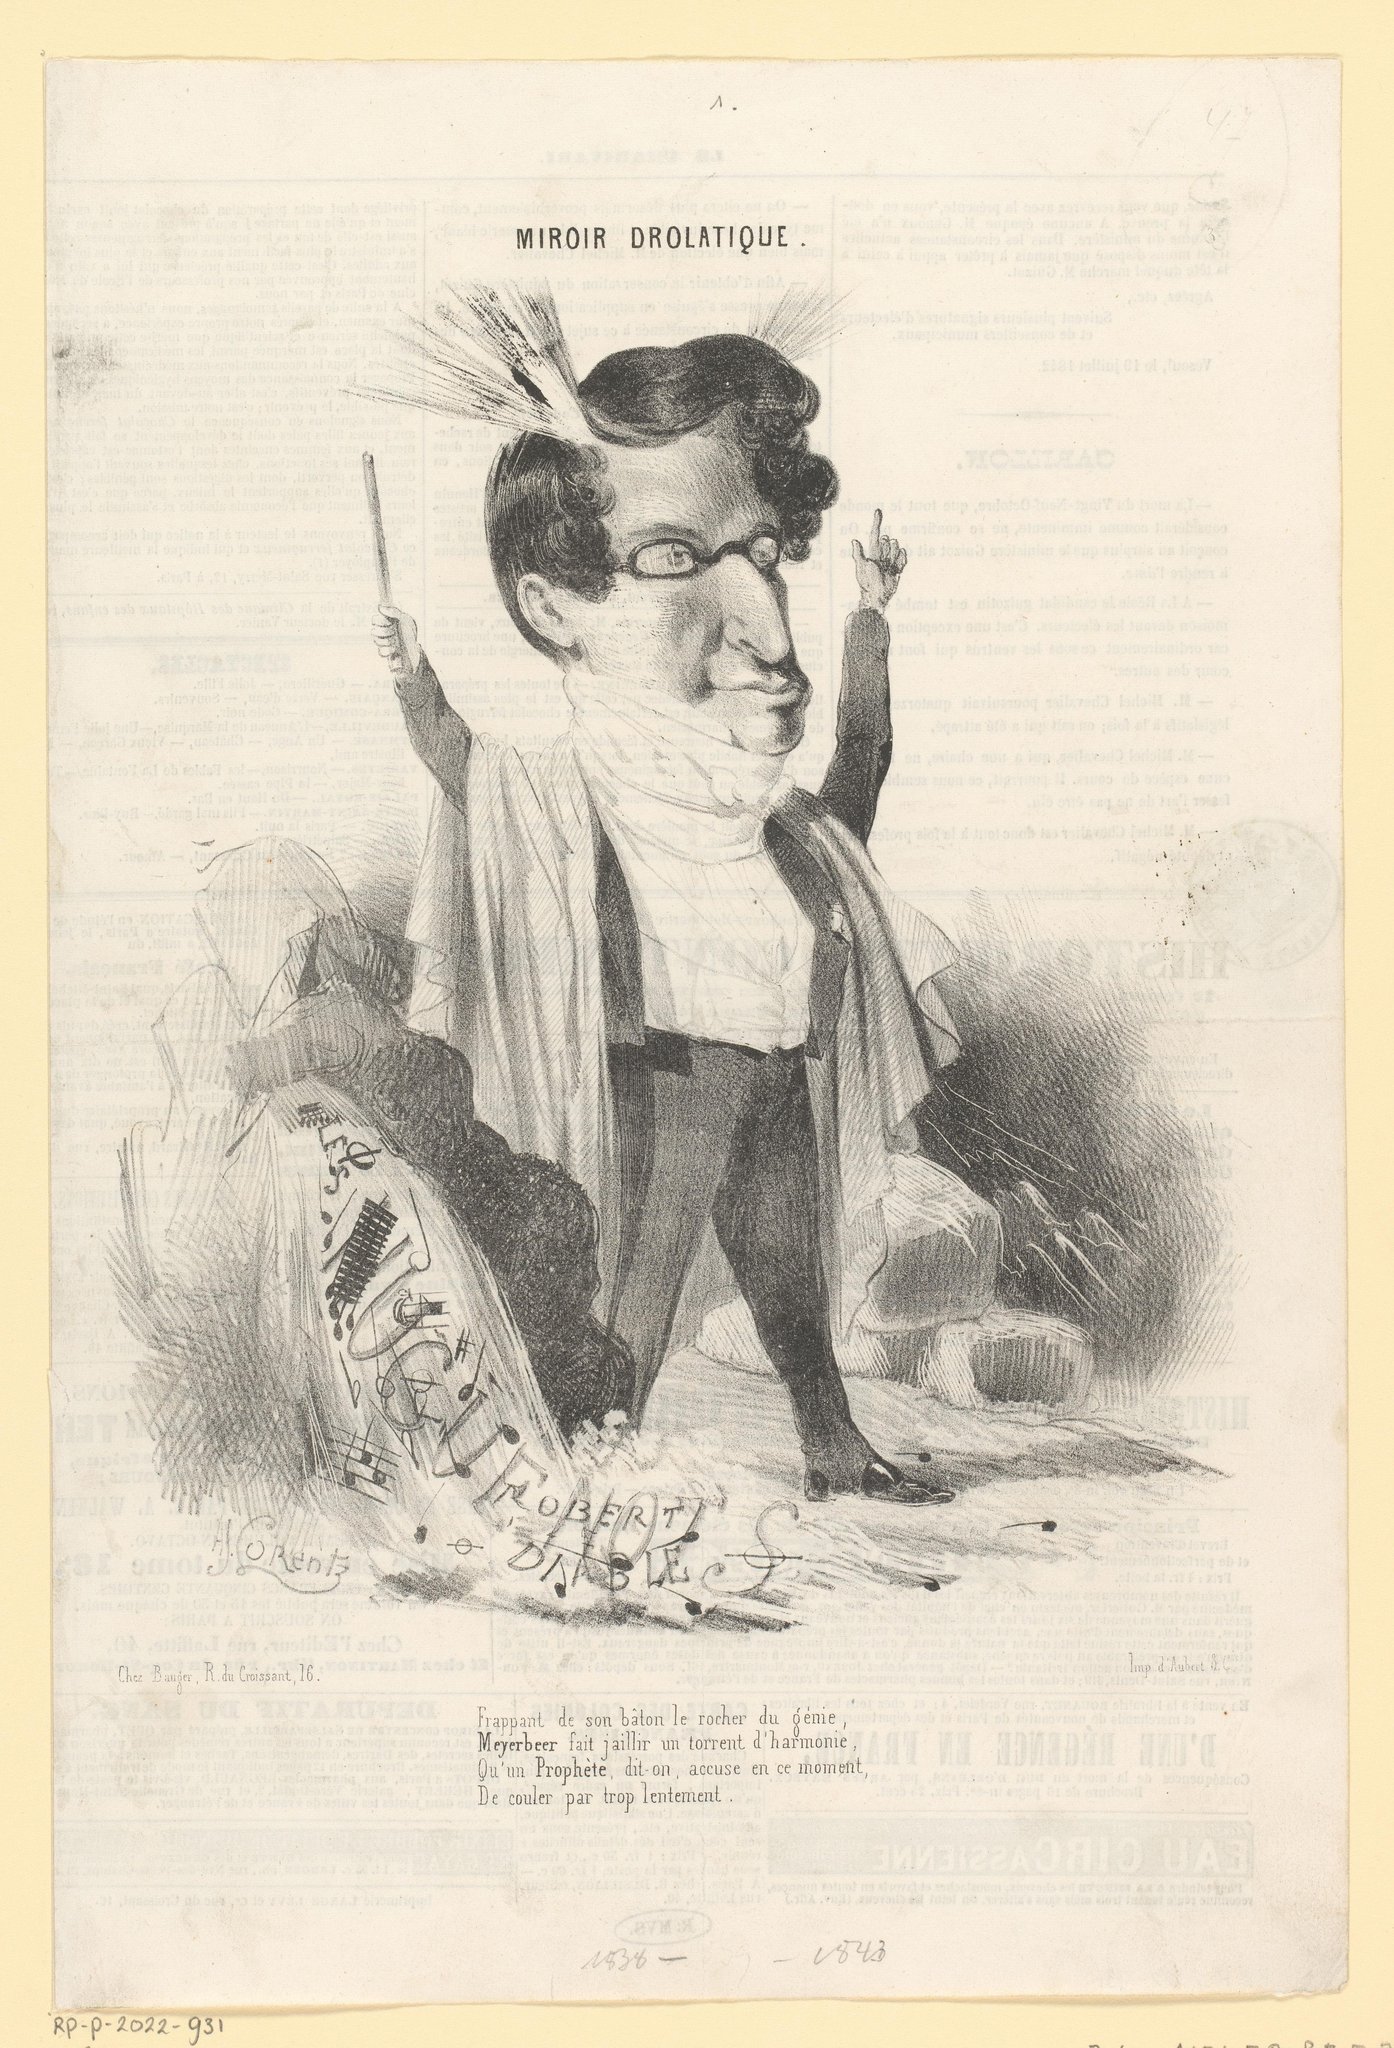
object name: print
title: Panthéon Charivarique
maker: alcide joseph lorentz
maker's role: print maker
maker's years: 1813-1889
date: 1842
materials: paper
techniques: letterpress printing, lithograph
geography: paris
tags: berlin, paris, giacomo meyerbeer, historical persons, portrait of composer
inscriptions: : ‘TIMBRE ROYAL 3c. / Seine.’, collector's mark: Lugt 2228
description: Prent uit: Le Charivari 203 (1842), vrijdag 22 juli, 1842, 11e jaargang.